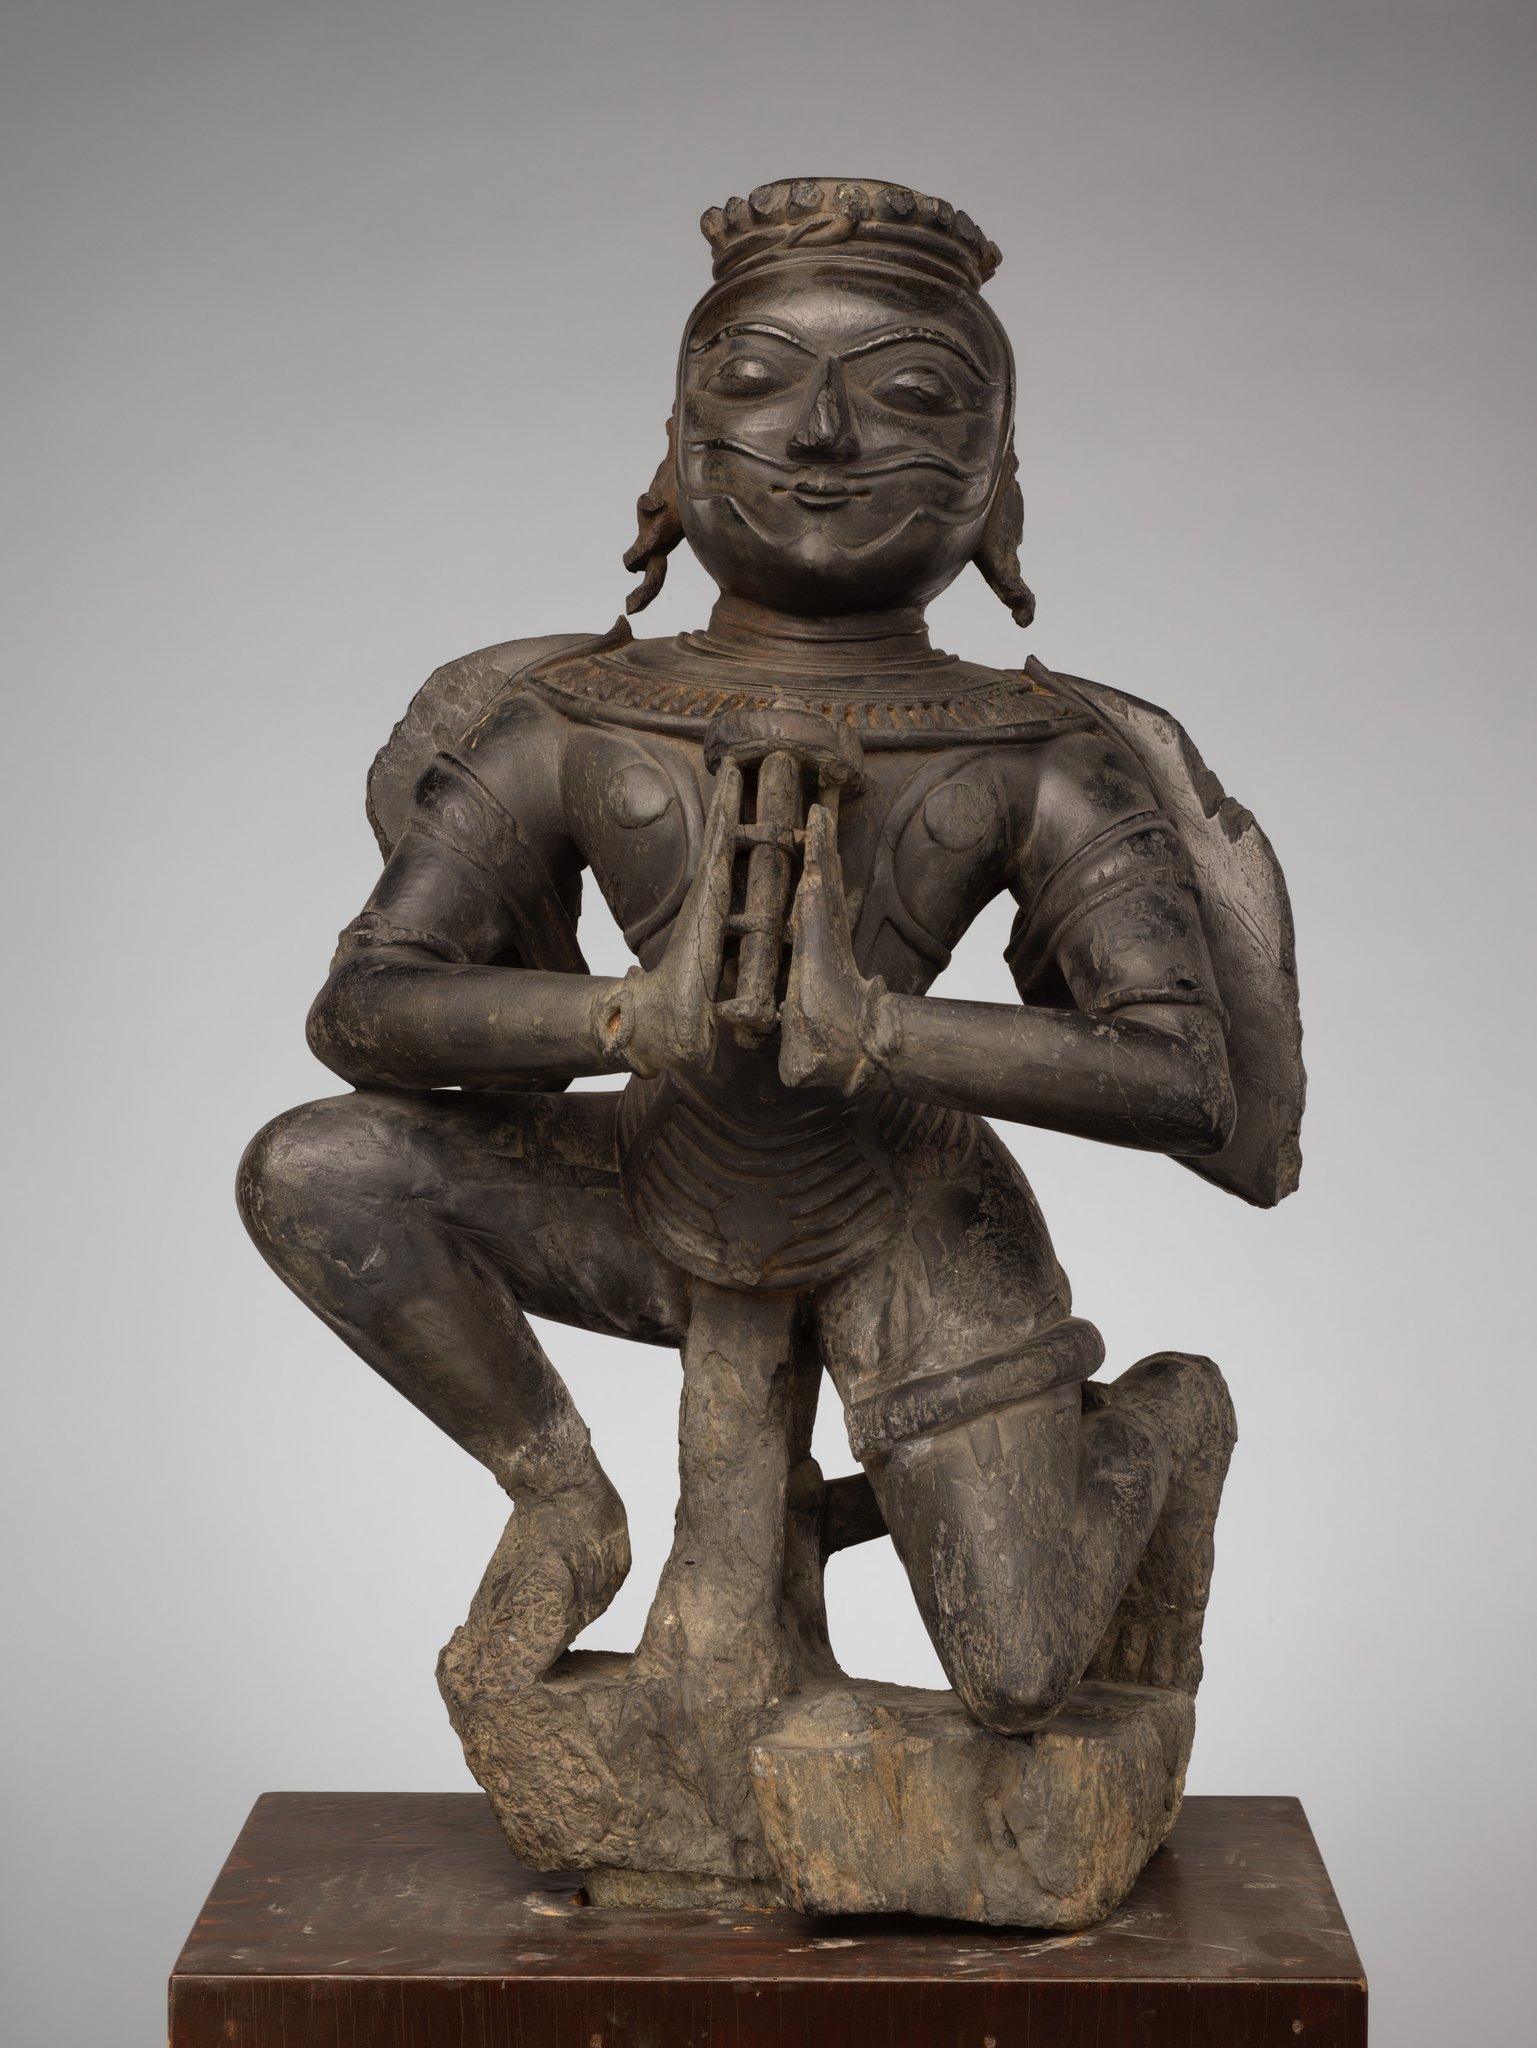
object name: figure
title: Kneeling Garuda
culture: indian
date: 1501-1600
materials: stone